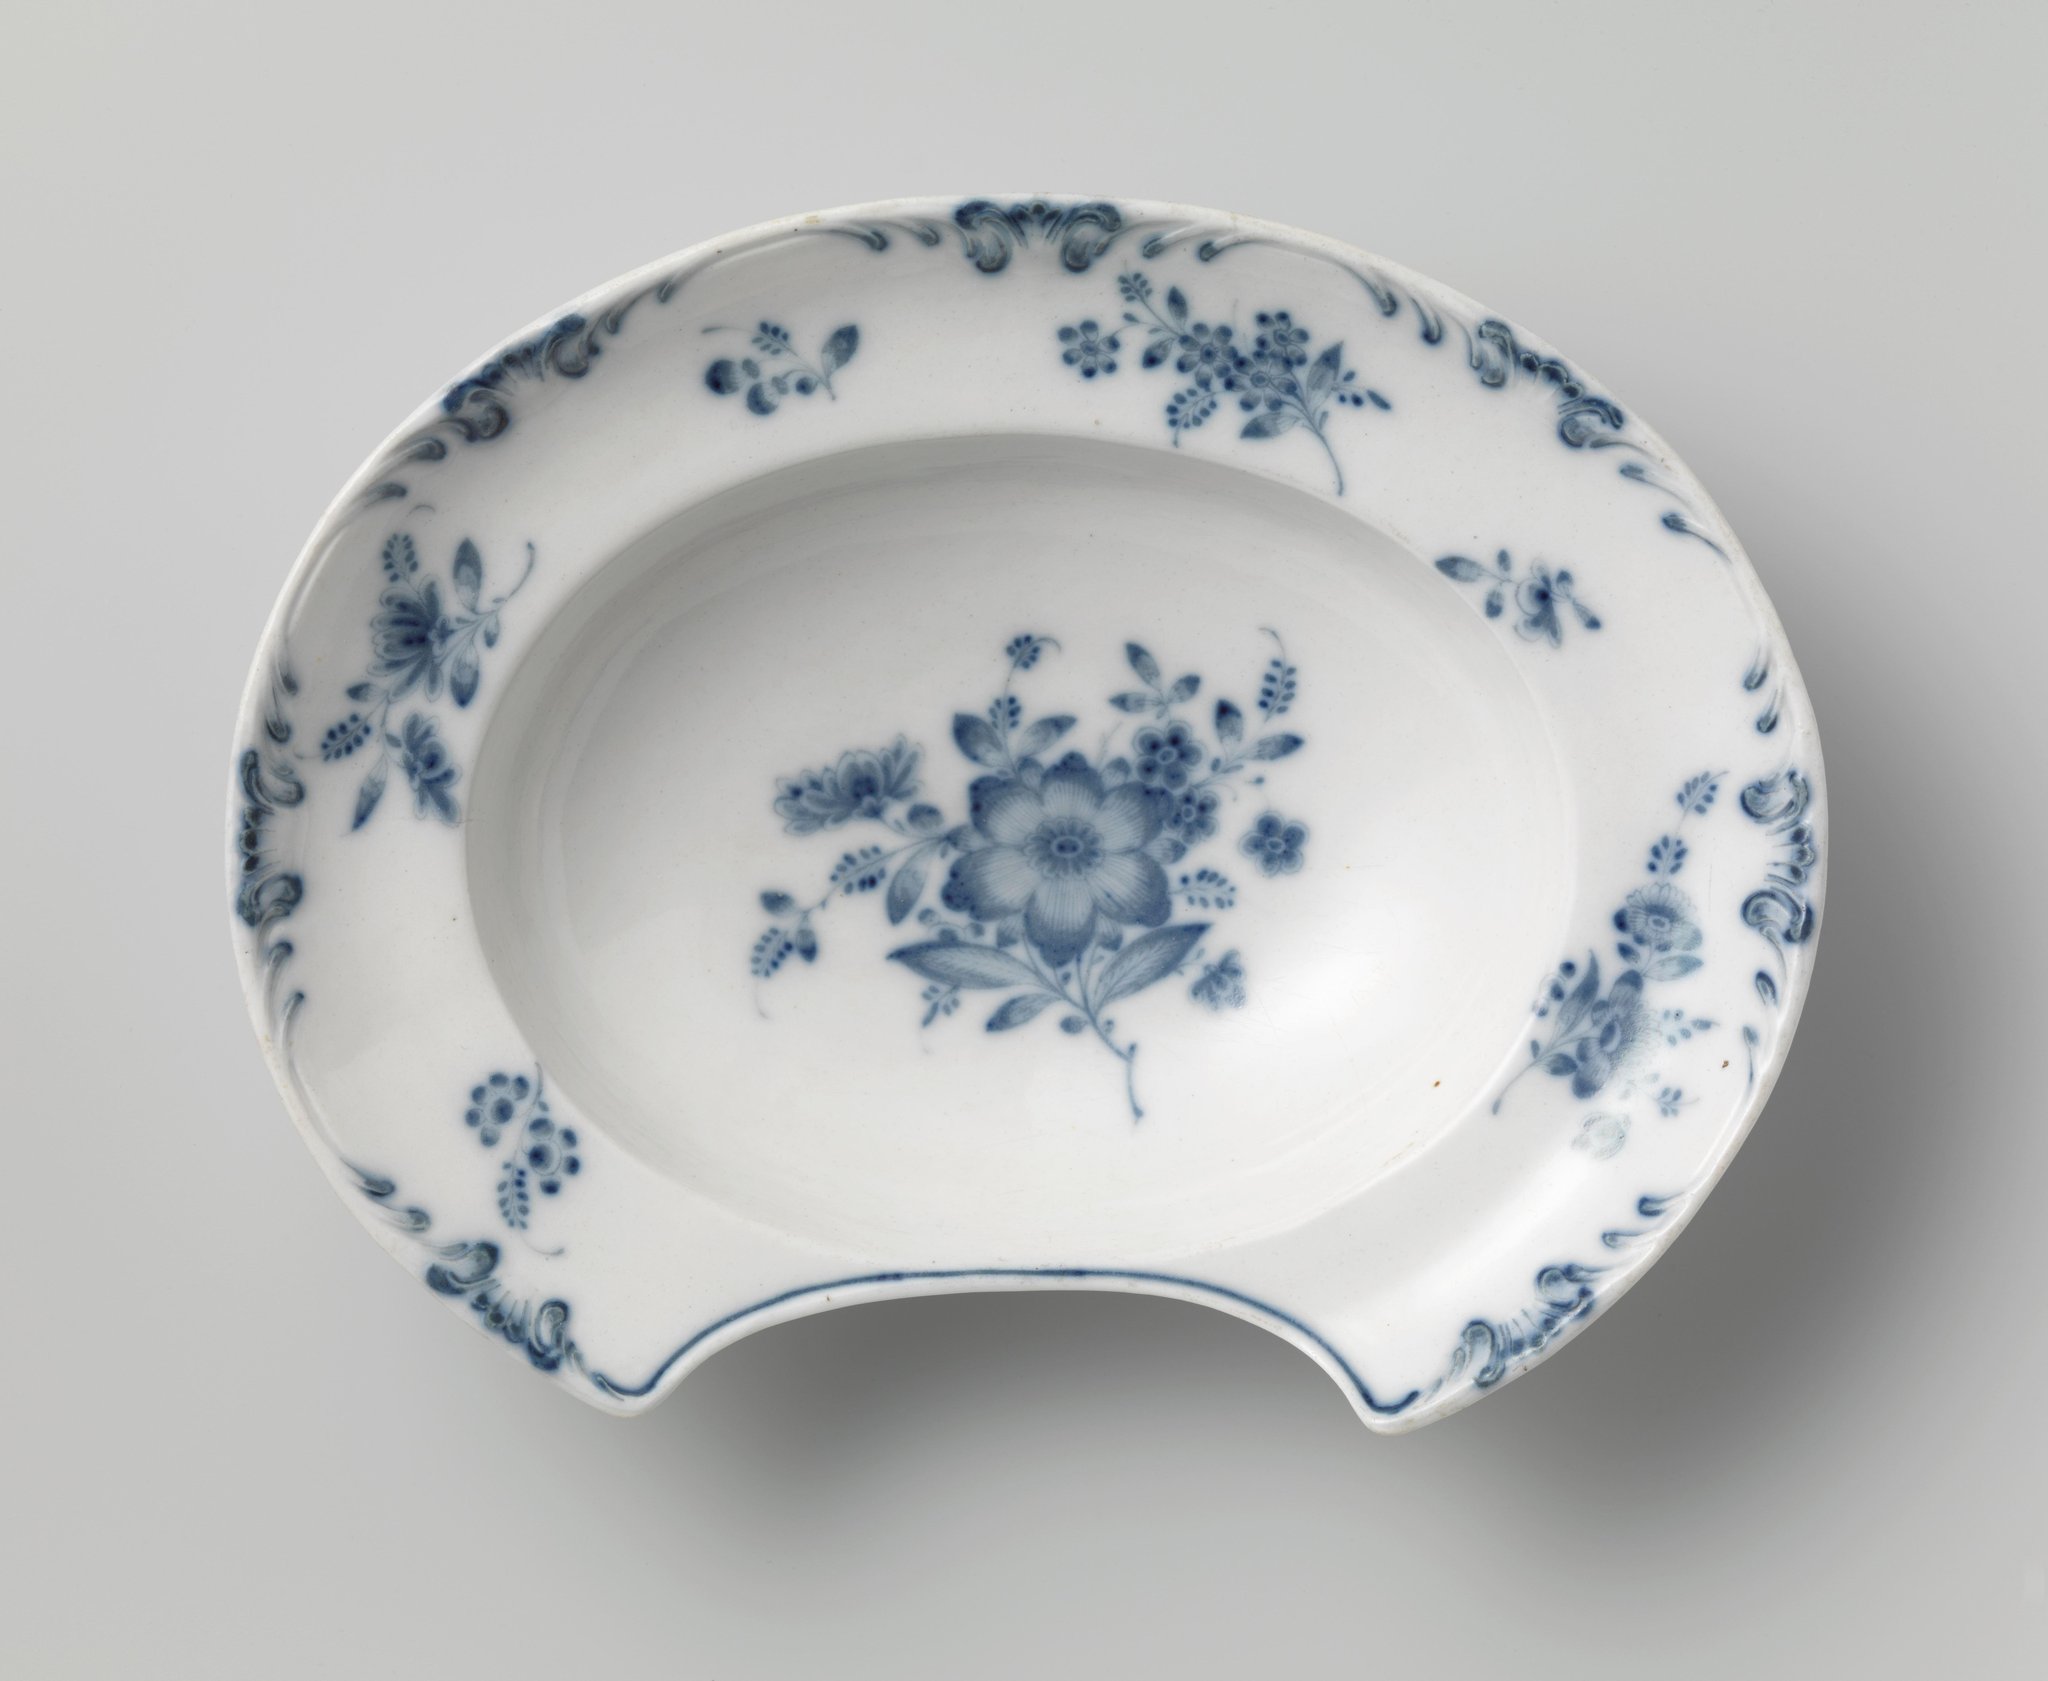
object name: shaving basin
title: Scheerbekken van porselein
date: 1774-1784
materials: porcelain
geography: loosdrecht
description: Barber's bowl. Porcelain, painted in underglaze blue. Loosdrecht, c. 1778 - 1782. Factory of Joannes de Mol.